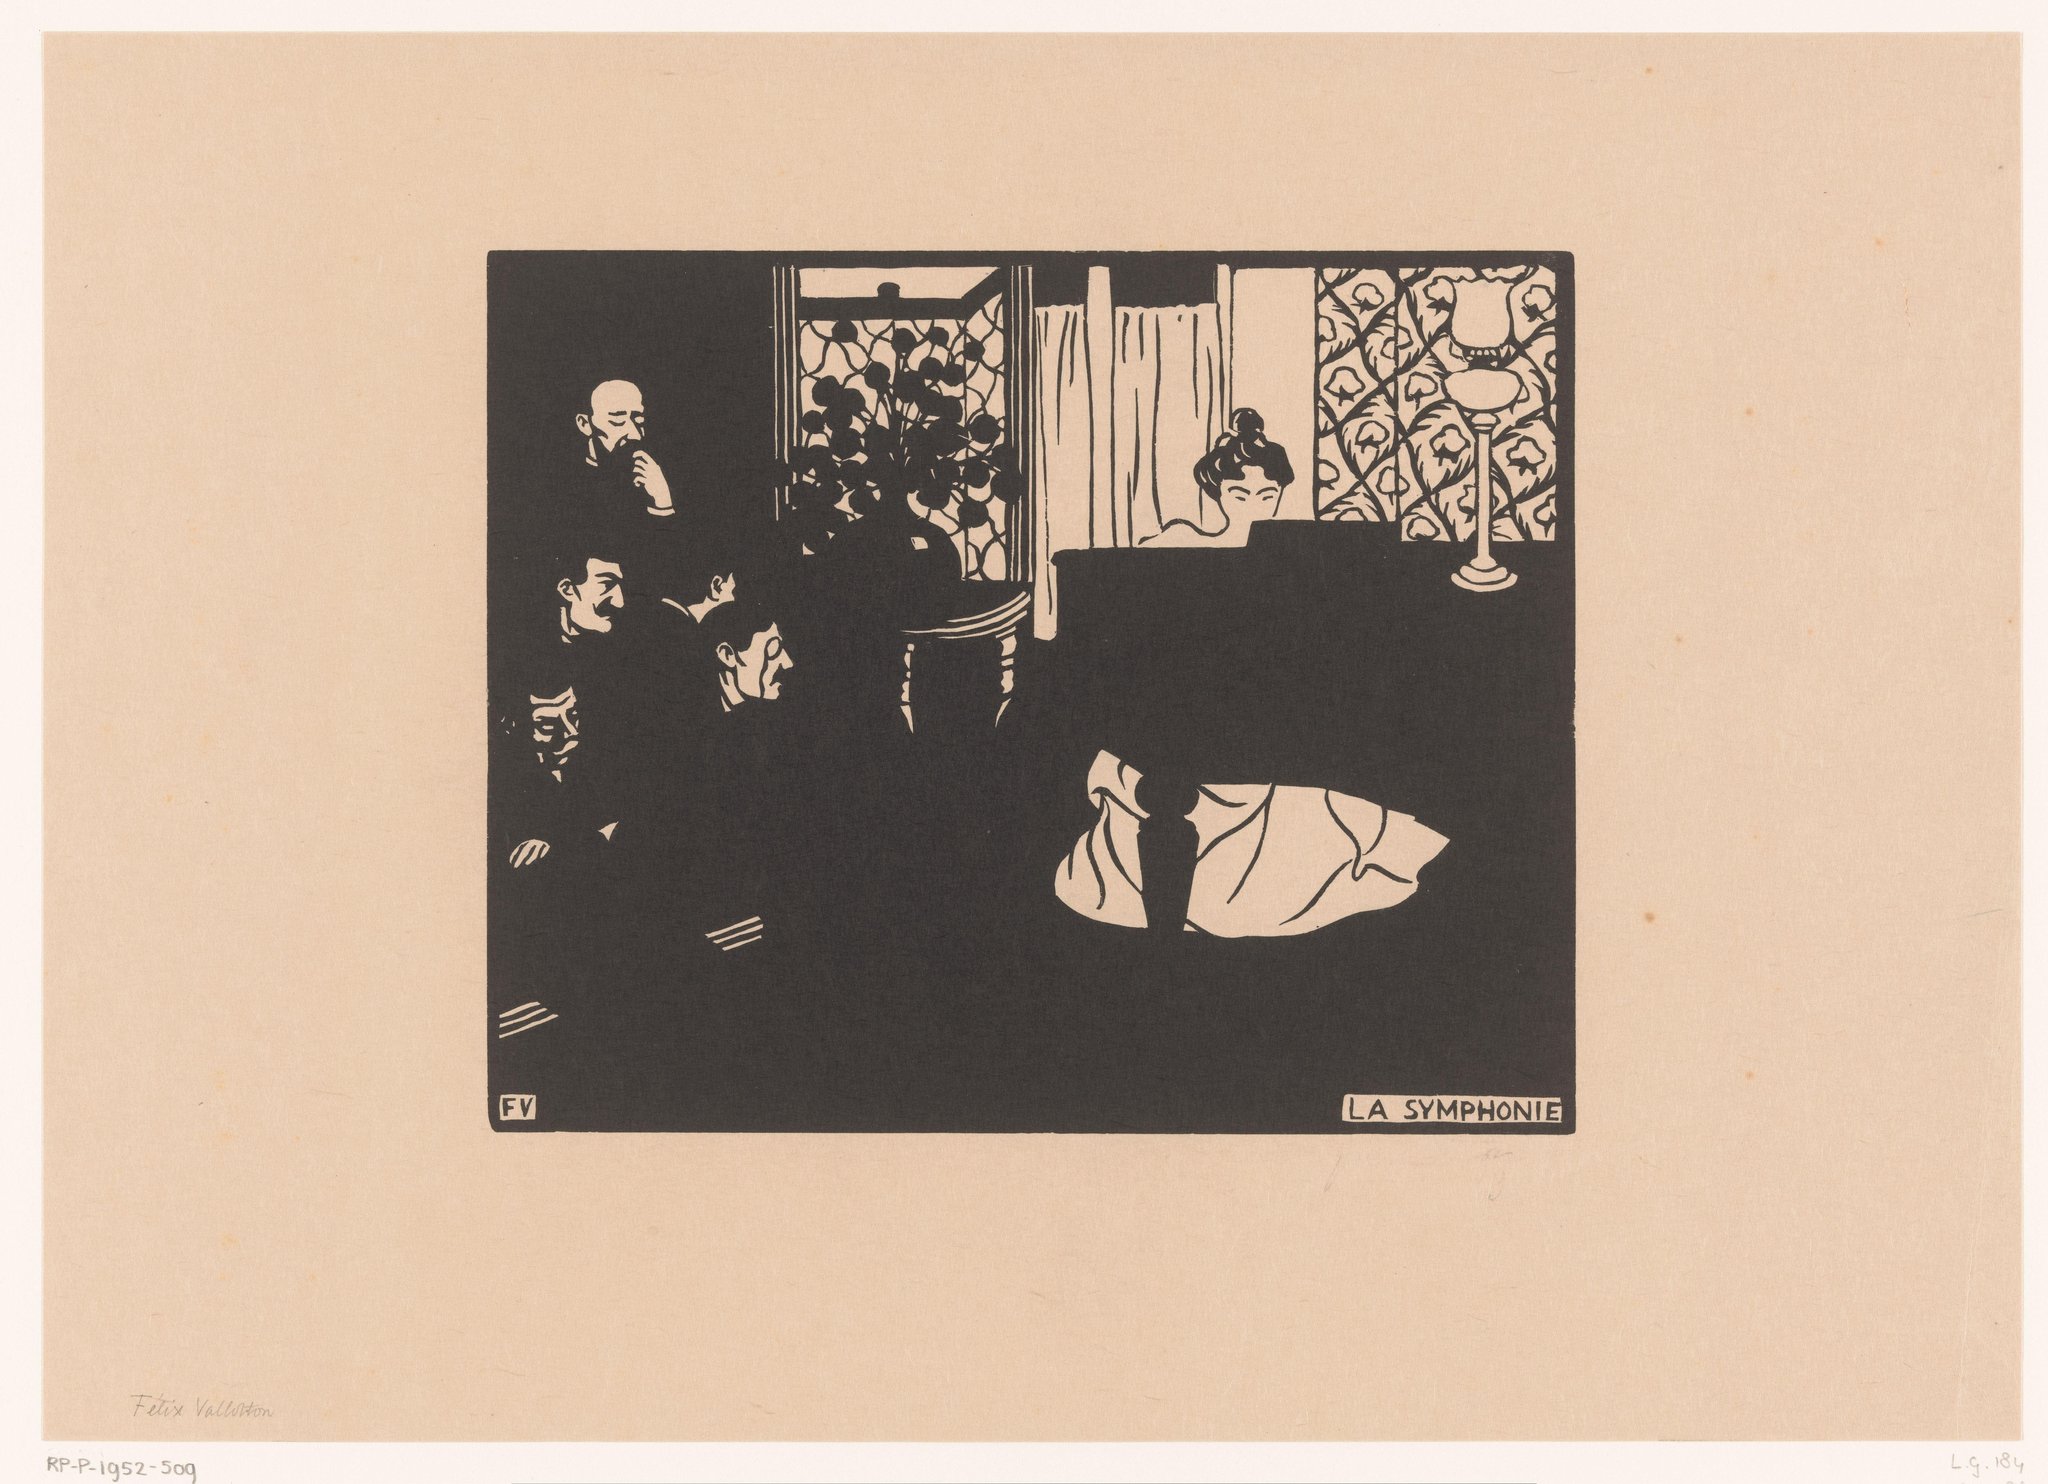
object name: print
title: Pianospelende dame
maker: félix edouard vallotton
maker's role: print maker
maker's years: 1865-1925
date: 1897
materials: paper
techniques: woodcut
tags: one person playing keyboard instrument, listening to music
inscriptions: collector's mark: Lugt 2228